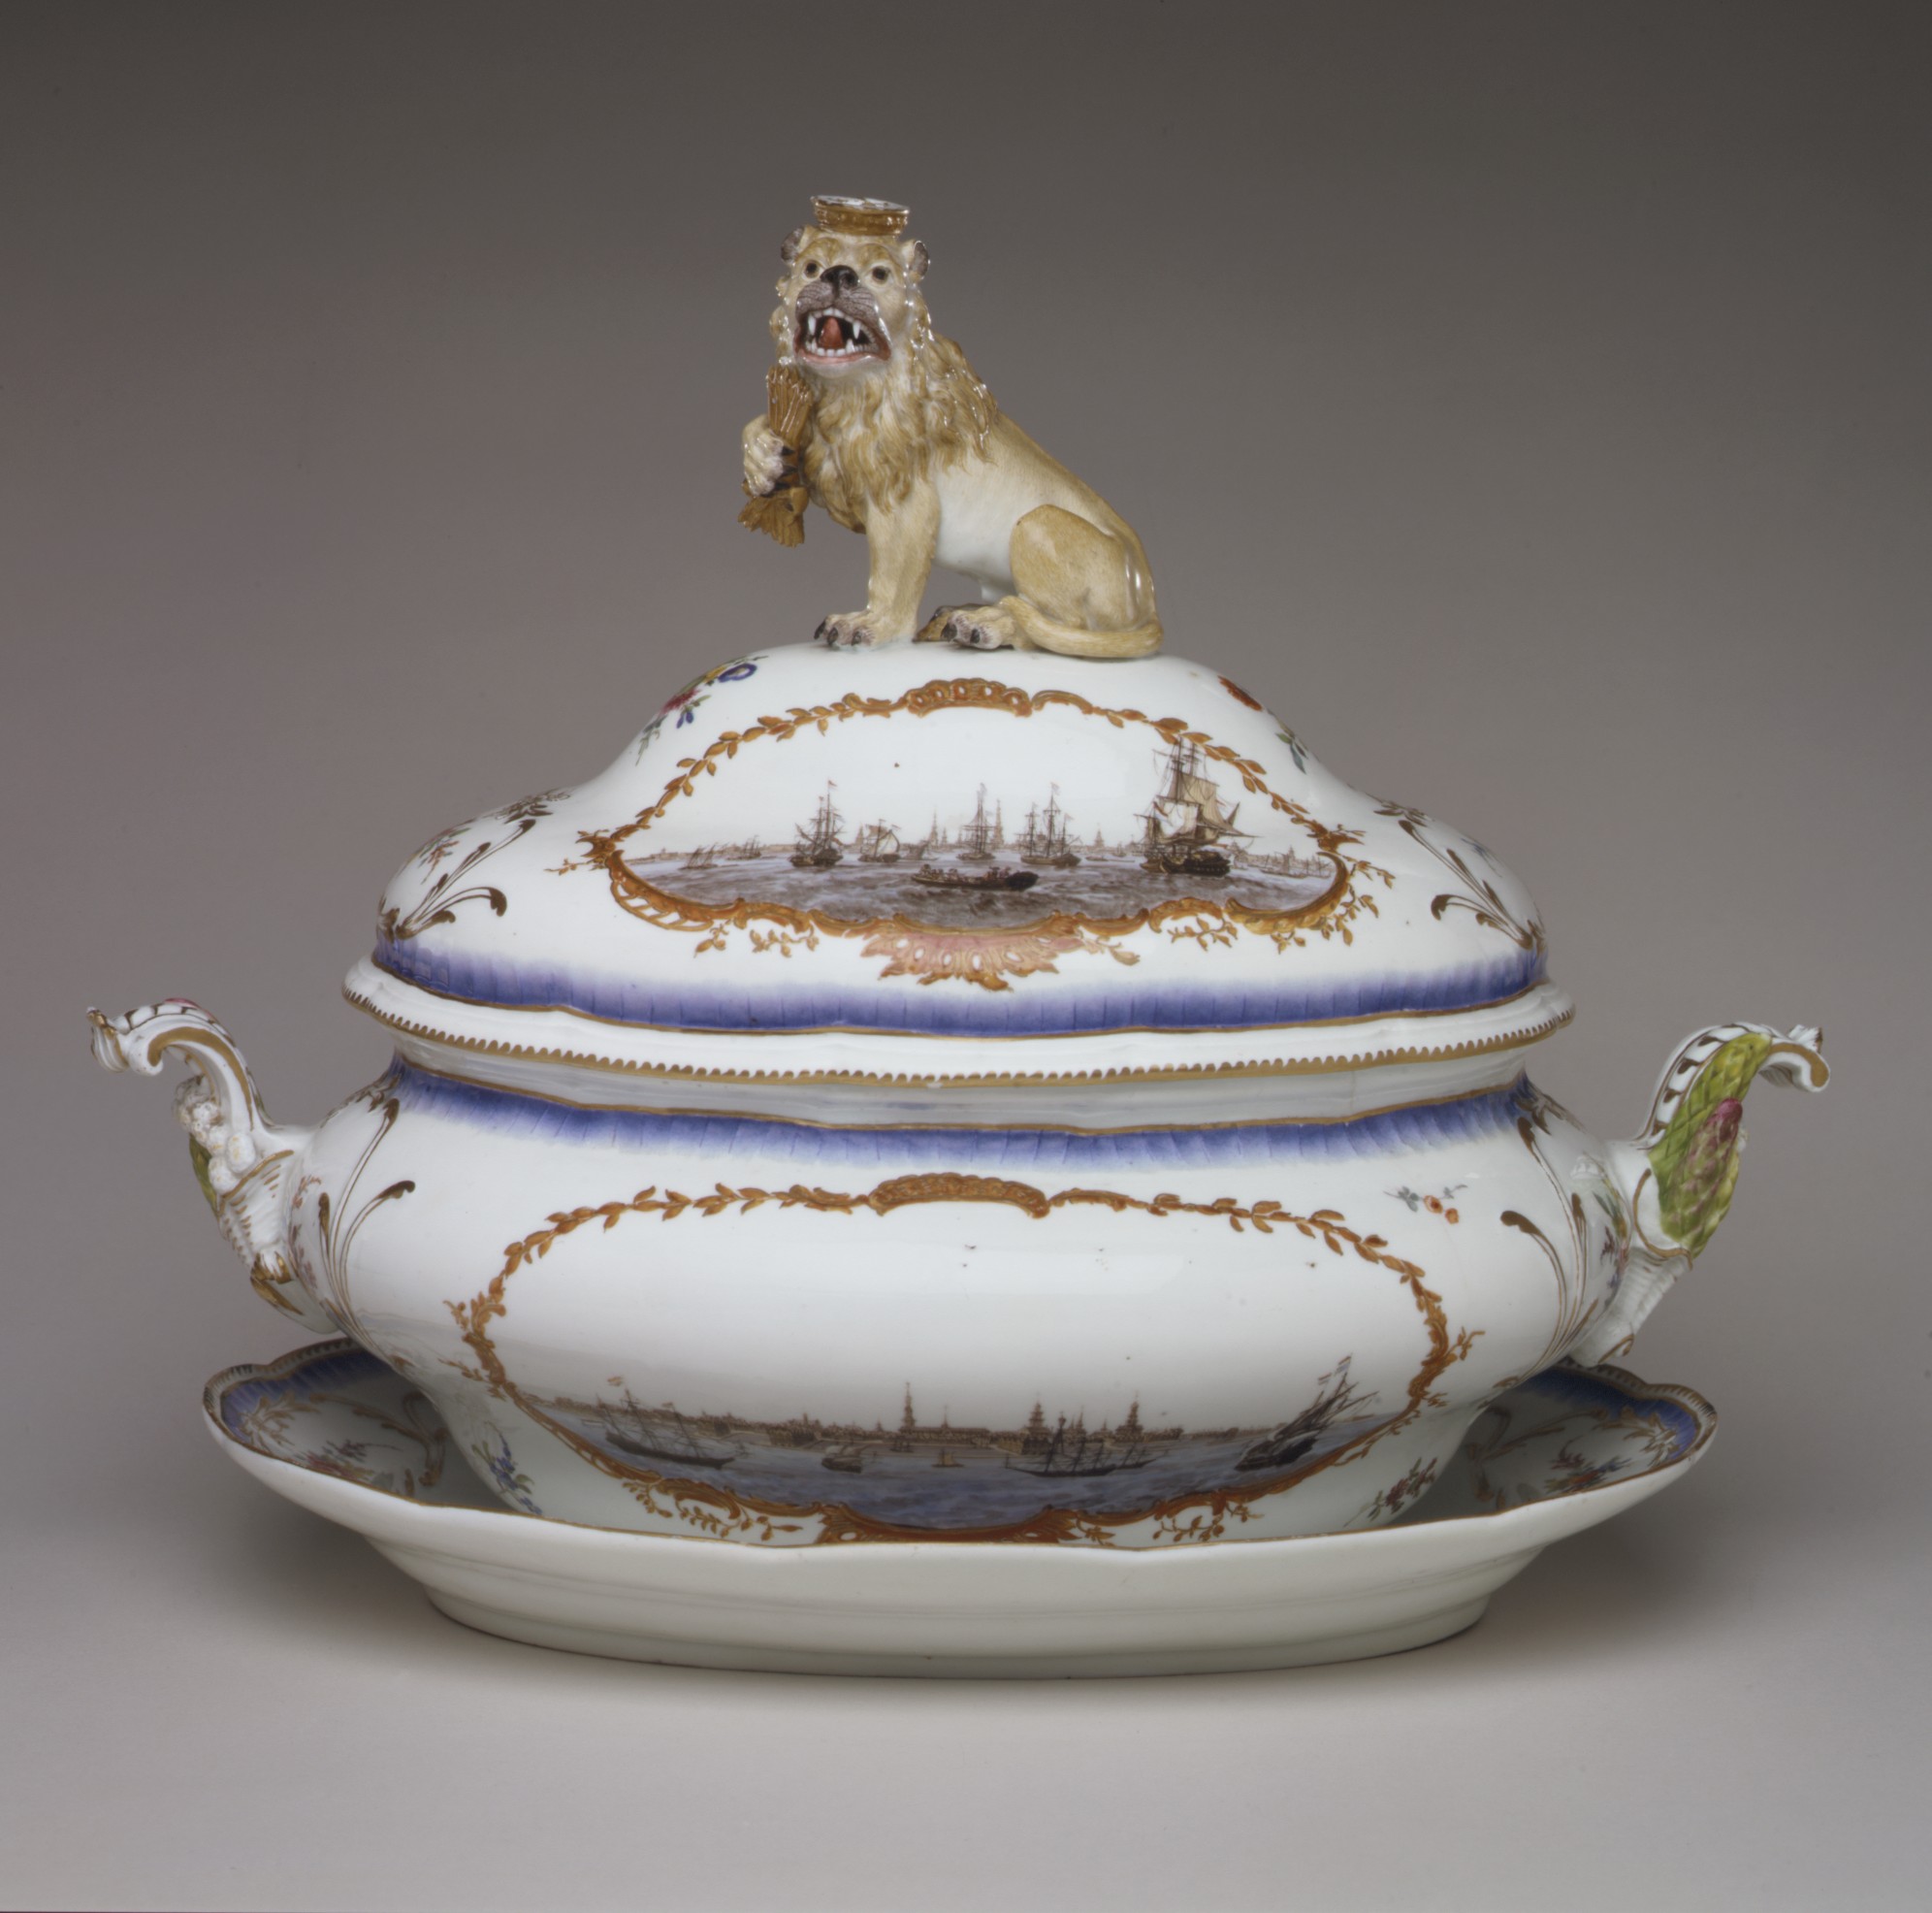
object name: tureen with cover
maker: meissen manufactory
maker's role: manufactory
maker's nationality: german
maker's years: 1710-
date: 1772-1774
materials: hard paste porcelain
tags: lions,ships